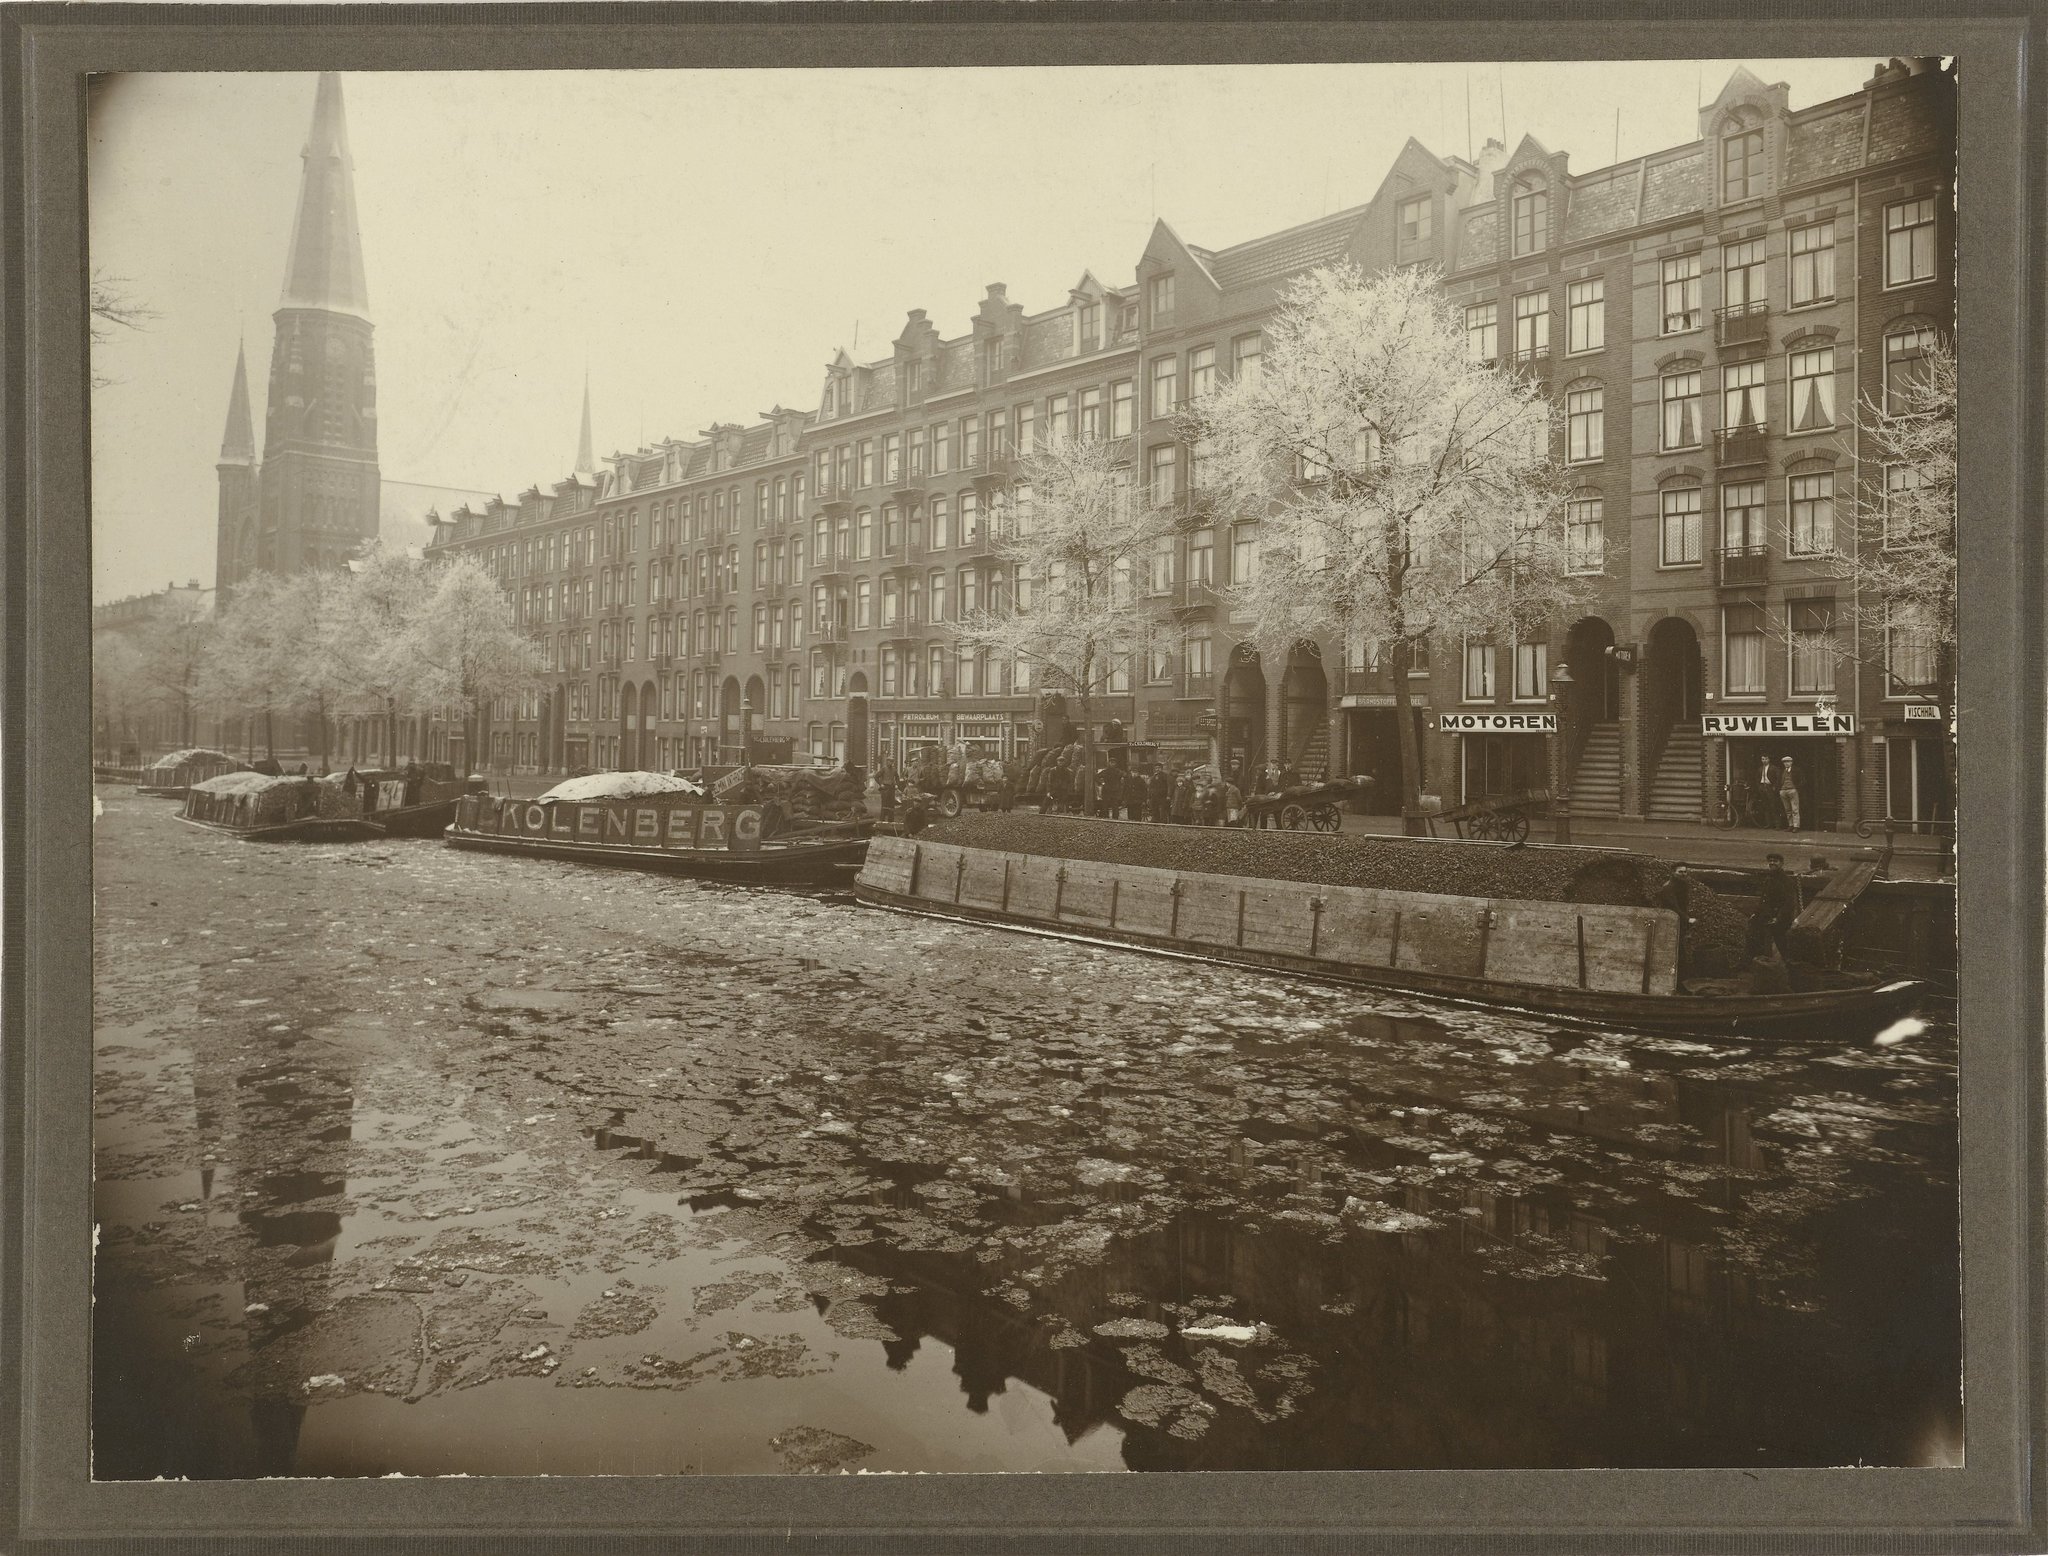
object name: photograph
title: Beplakte muur met affiches in Amsterdam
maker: Anonymous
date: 1880-1920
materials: cardboard, paper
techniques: gelatin silver print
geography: amsterdam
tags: wall-covering, poster, amsterdam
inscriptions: signature: ‘N.V. Vereenigde Foto-bureaux Prinsengracht 868 Amsterdam’